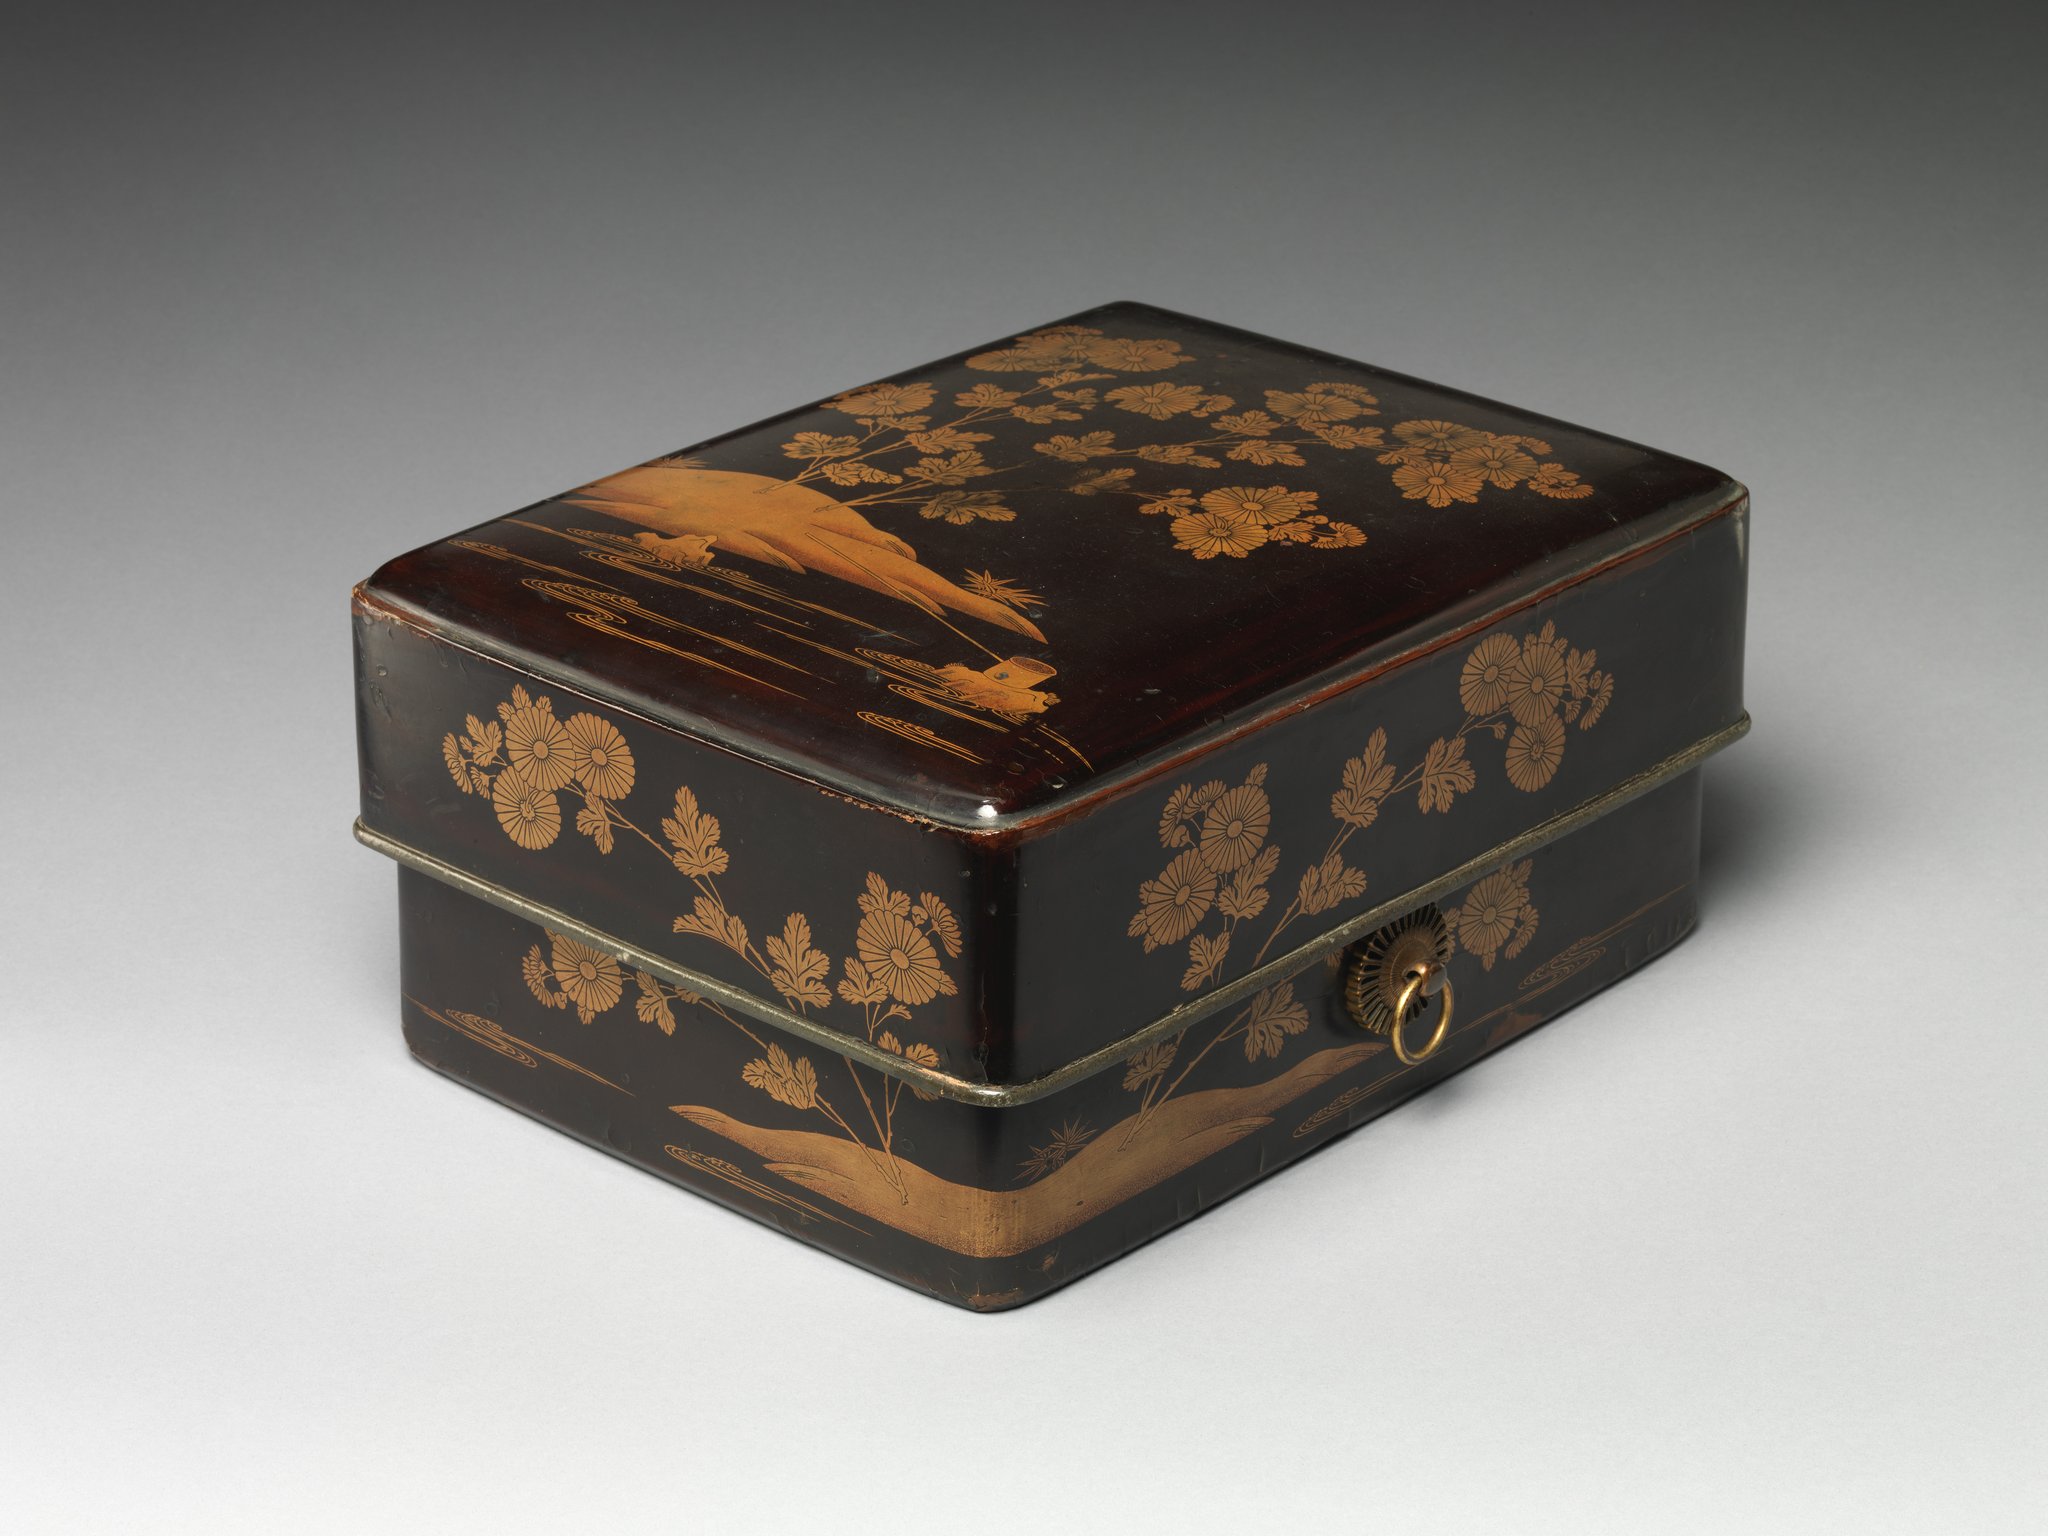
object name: box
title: Box for Accessories (Tebako) with Chrysanthemum Boy (Kikujidō) Pattern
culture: japanese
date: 1601-1633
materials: gold, lacquer, wood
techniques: lacquer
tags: flowers